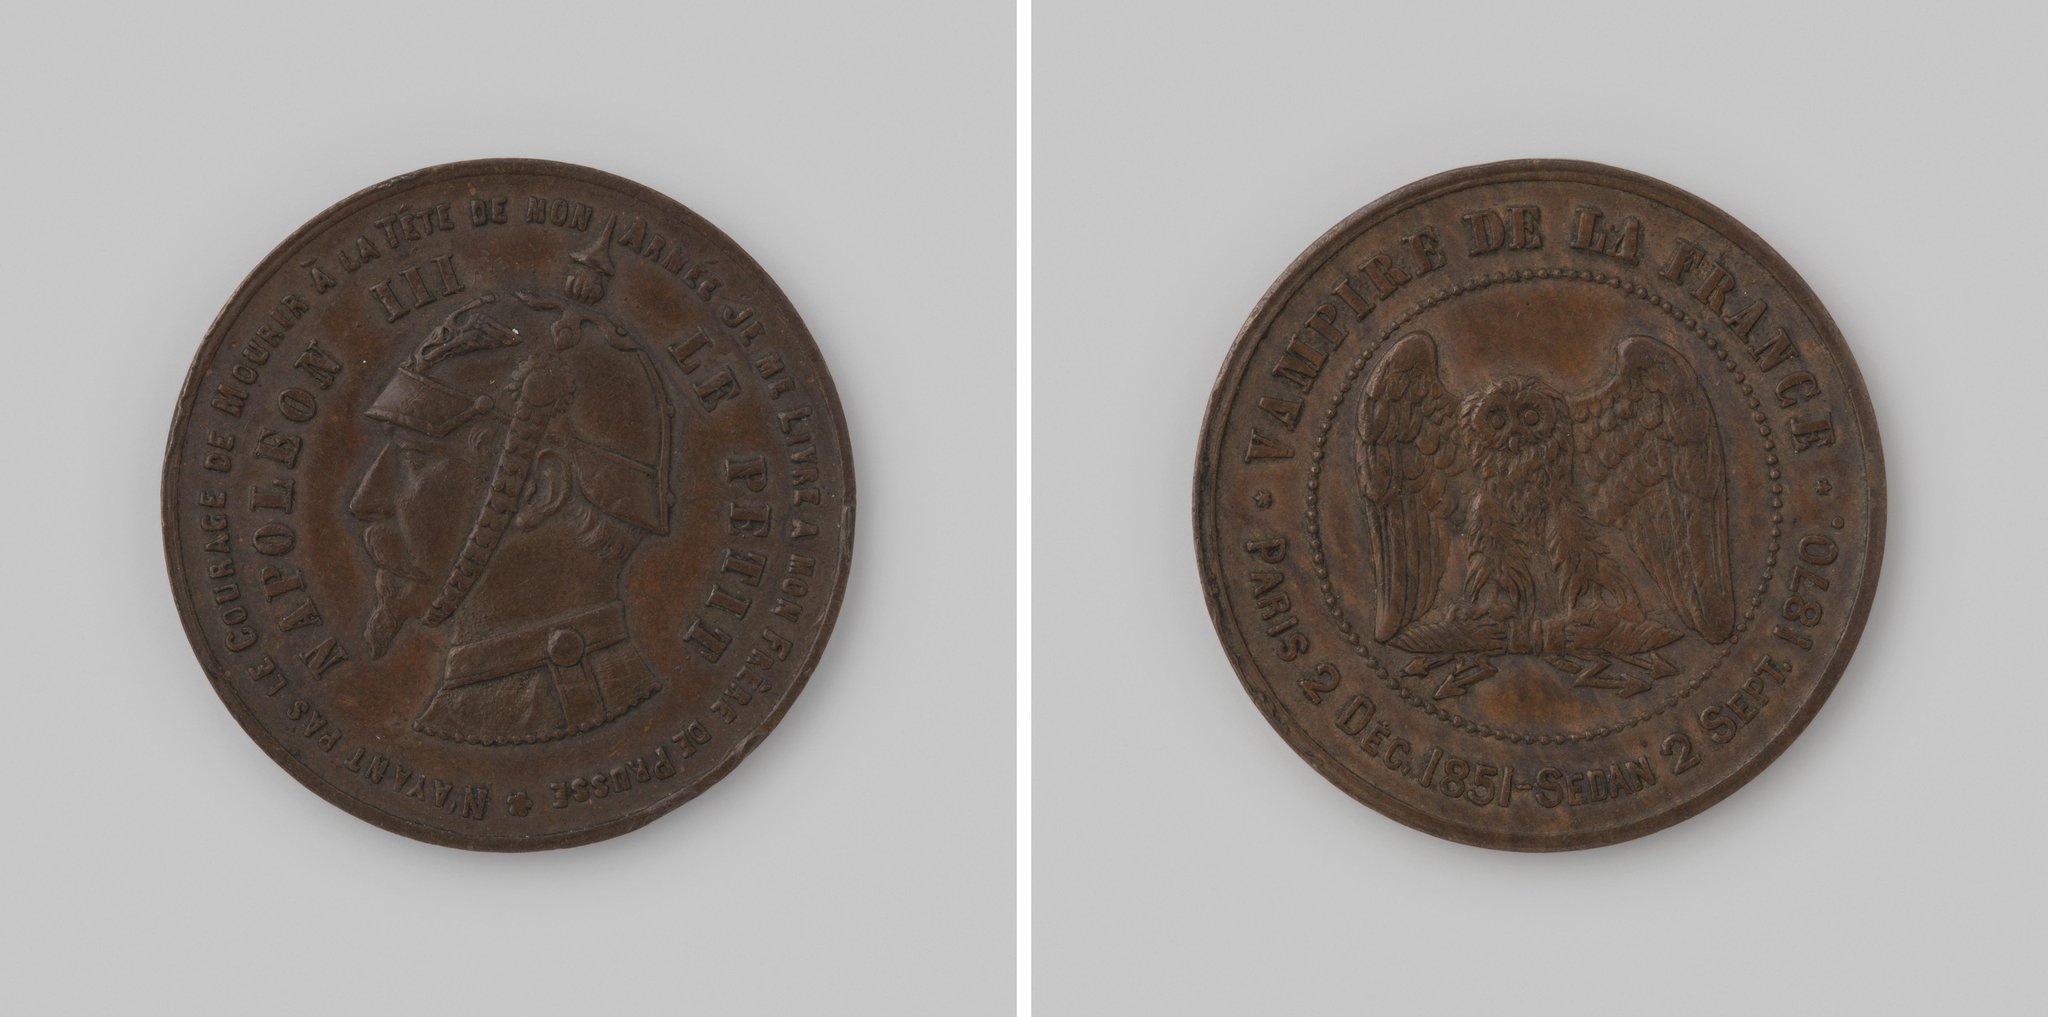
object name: tien centime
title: Spotpenning van na 1870, gebaseerd op 10 centimes uit het keizerrijk Frankrijk van Napoleon III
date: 1871-1875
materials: bronze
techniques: striking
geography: straatsburg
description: Bronzen spotpenning van na de nederlaag tegen Duitsland, gebasserd op munt van 10 centimes van keizer Napoleon III. Voorzijde: borstbeeld van de keizer naar links. Hoofd voorzien van Duitse helm. Keerzijde: uil[skuiken], gezeten op bundel, waaruit bliksemschichten, met gespreide vleugels. Op voorzijde en keerzijde beledigende omschriften. Gladde rand.